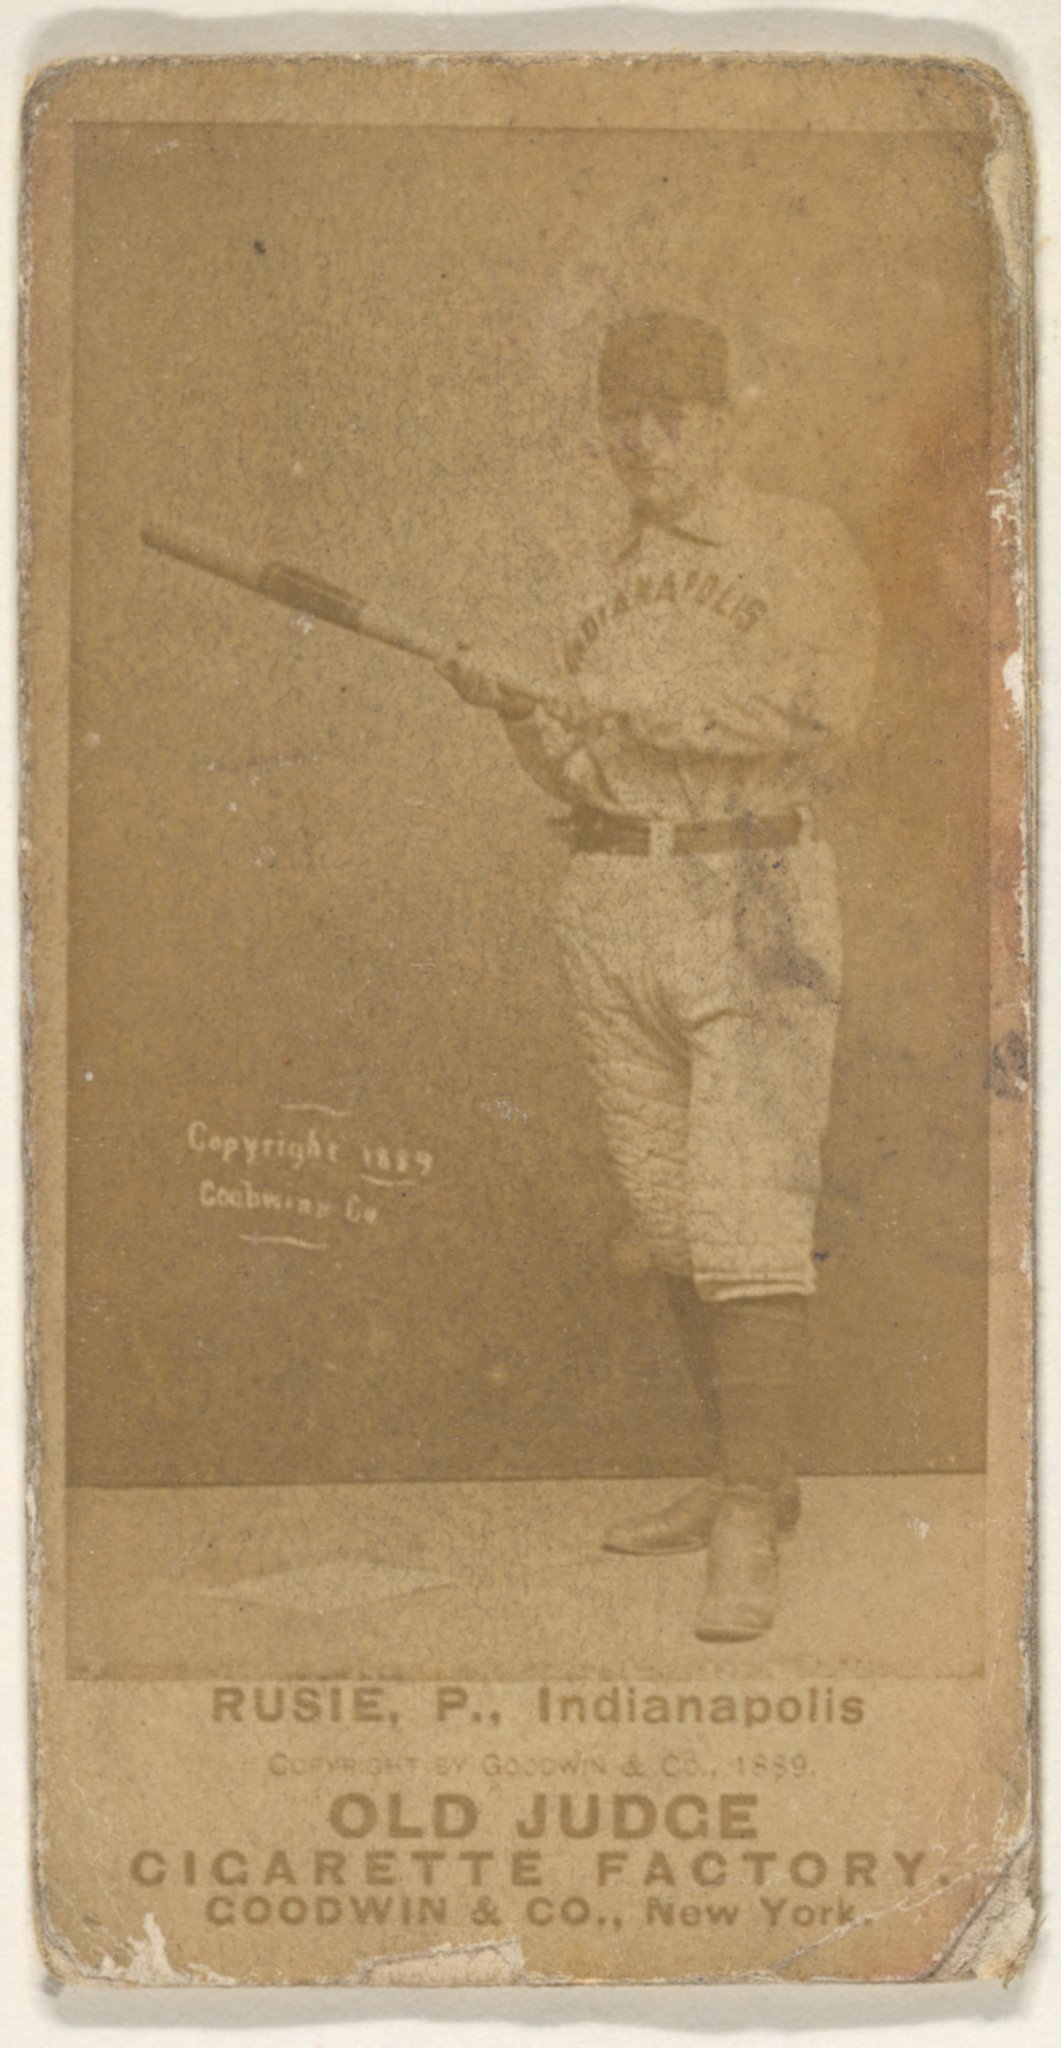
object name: baseball card, photograph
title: Amos Rusie, Pitcher, Indianapolis, from the Old Judge series (N172) for Old Judge Cigarettes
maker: goodwin & company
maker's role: publisher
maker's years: 1850-1950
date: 1889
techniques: albumen silver print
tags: men,portraits,baseball,athletes